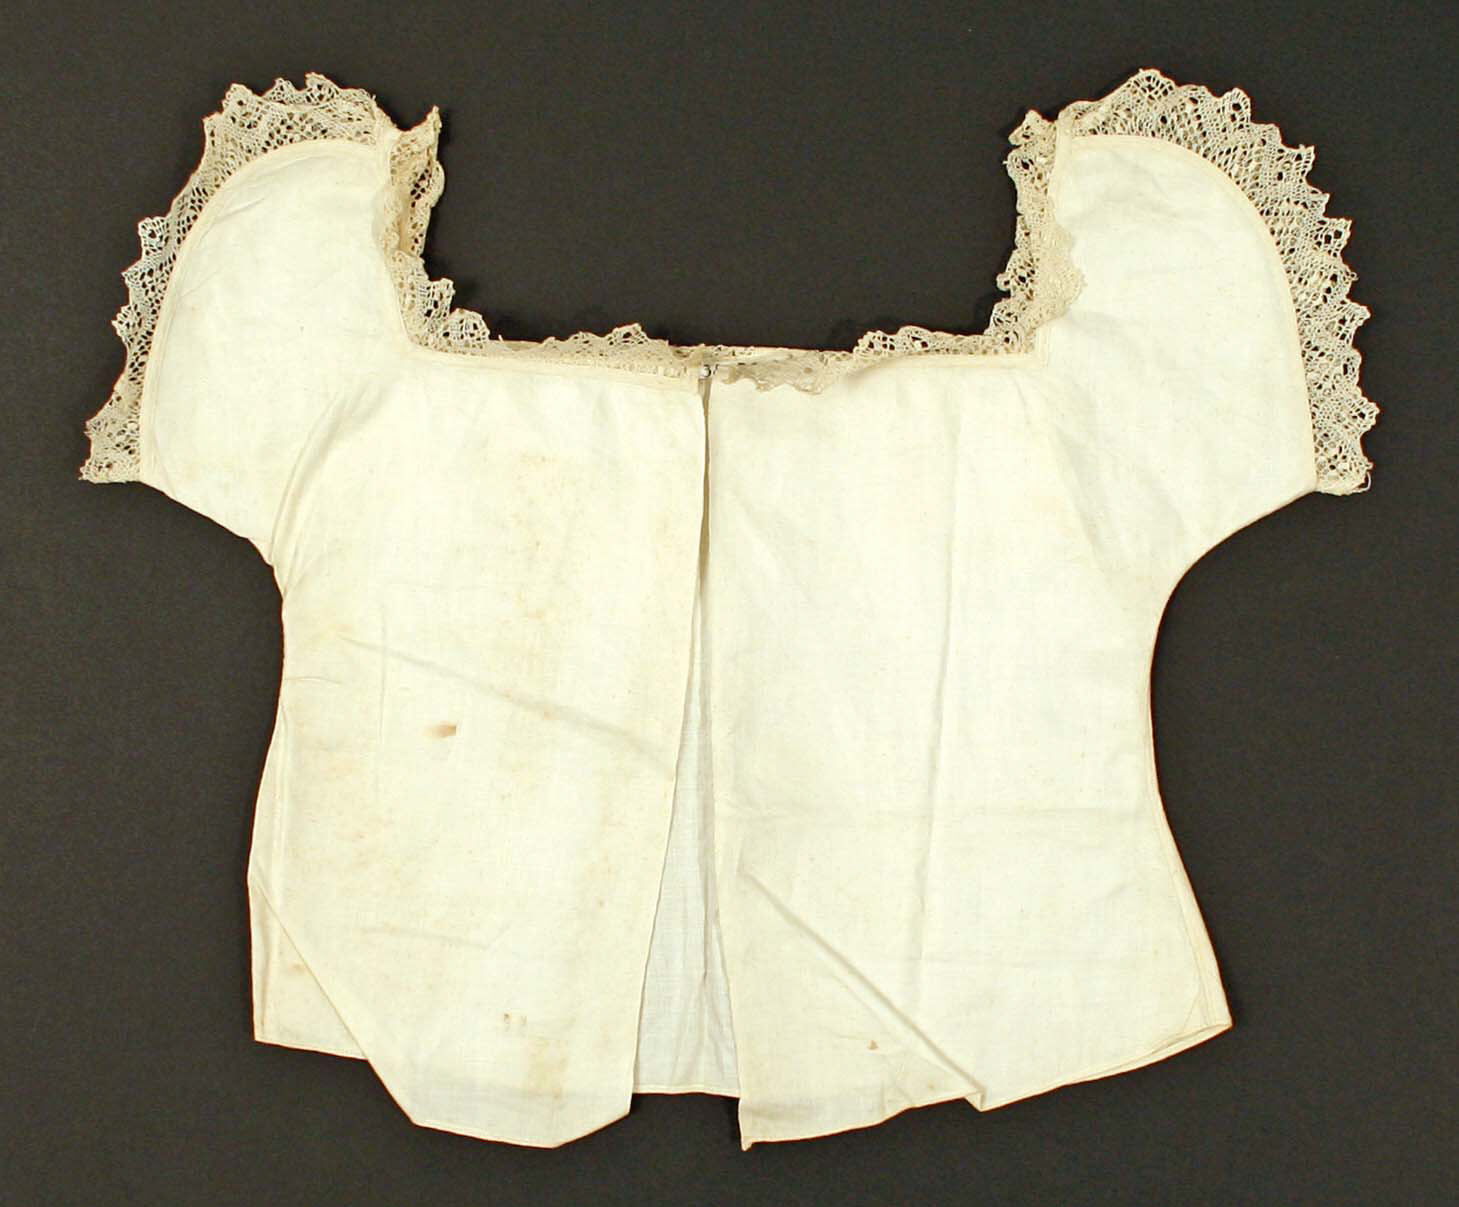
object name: shirt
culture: american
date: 1880-1881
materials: lace, linen